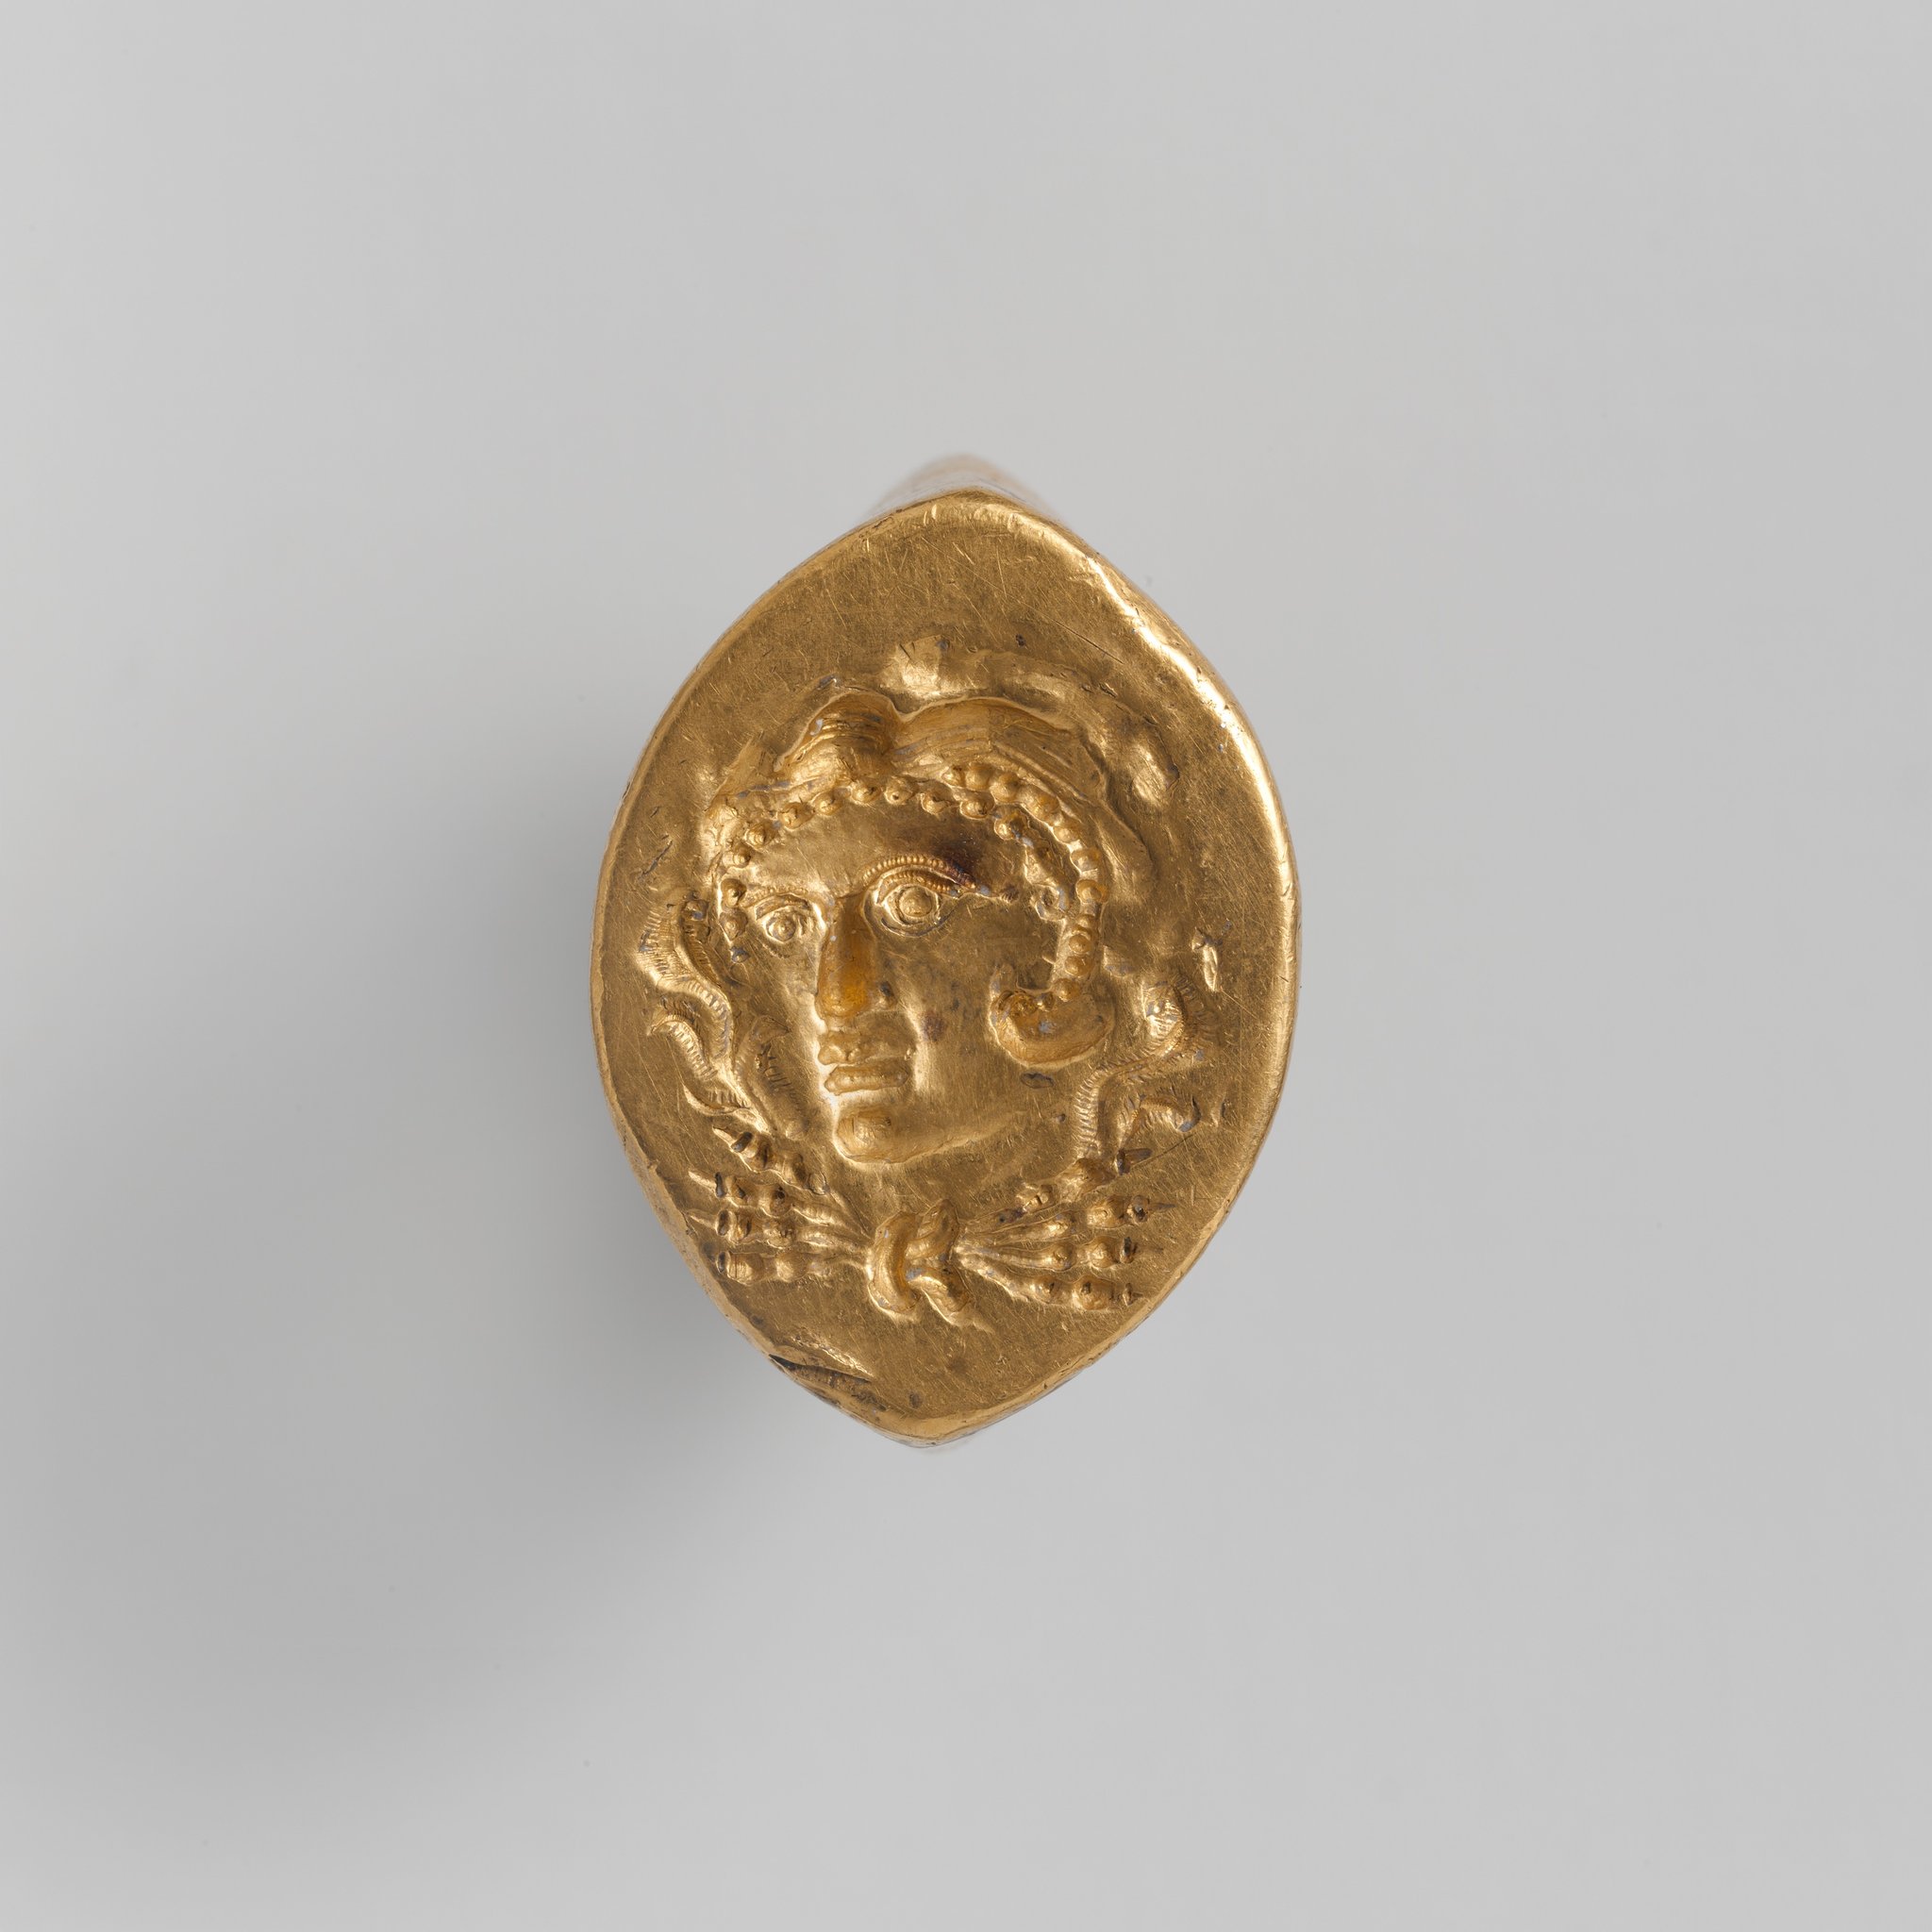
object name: ring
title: Gold ring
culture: greek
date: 334-201 BCE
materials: gold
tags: alexander the great,men